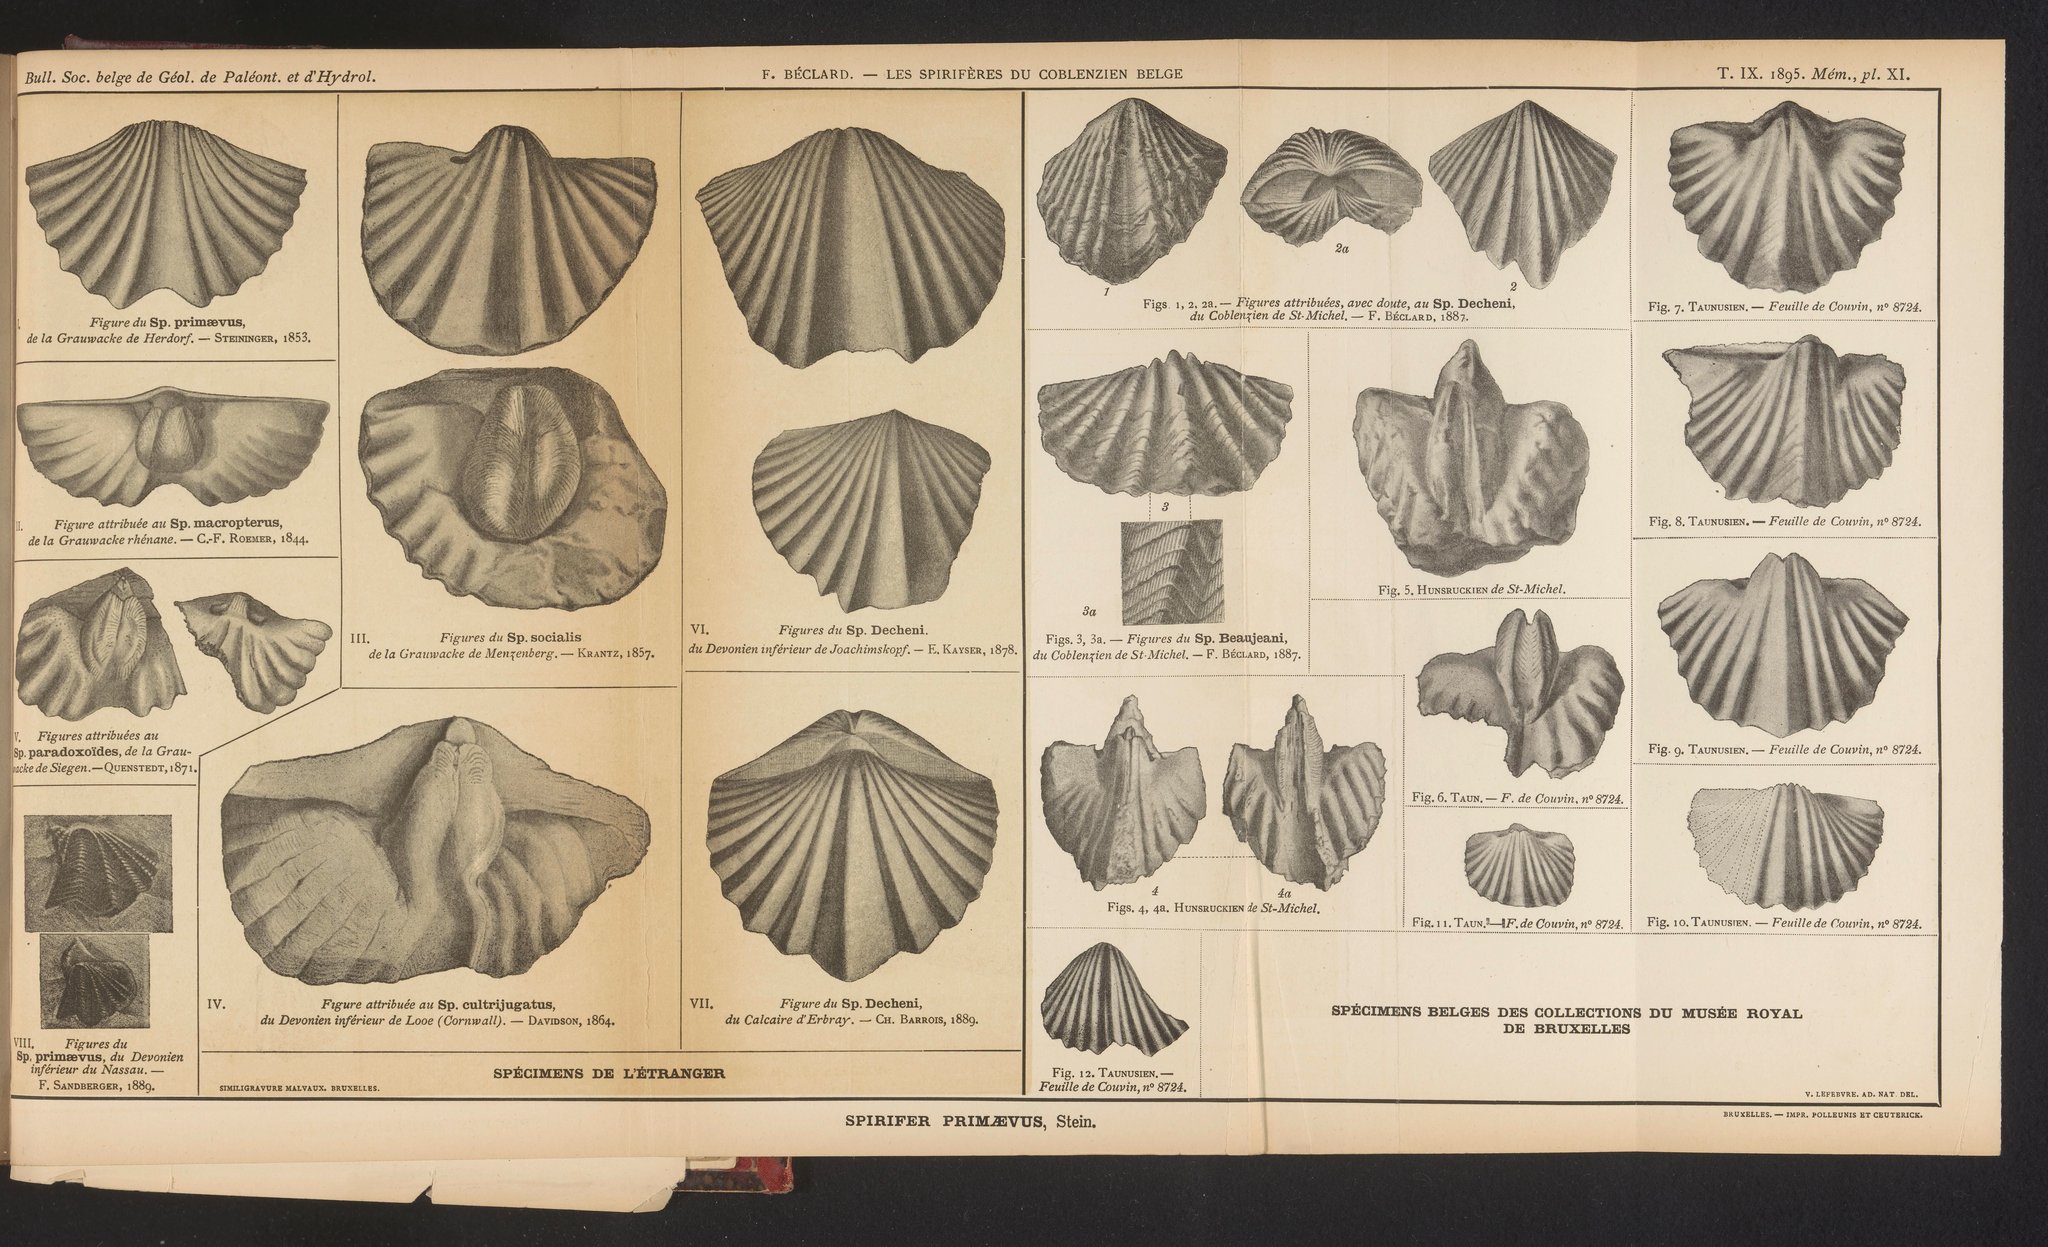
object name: photomechanical print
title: Verzameling gefossiliseerde armpotigen, Spirifer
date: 1889-1894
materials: paper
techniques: autotype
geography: brussels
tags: fossil animals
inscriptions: inscription: ‘V. Lefebvre. AD. NAT. DEL.’, inscription: ‘Bull. Soc. belge de Géol. de Paléont. et d'Hydrol./ F. Béclard. - les spirifères du coblenzien Belge/ T. IX 1895. Mém., pl. XI.’